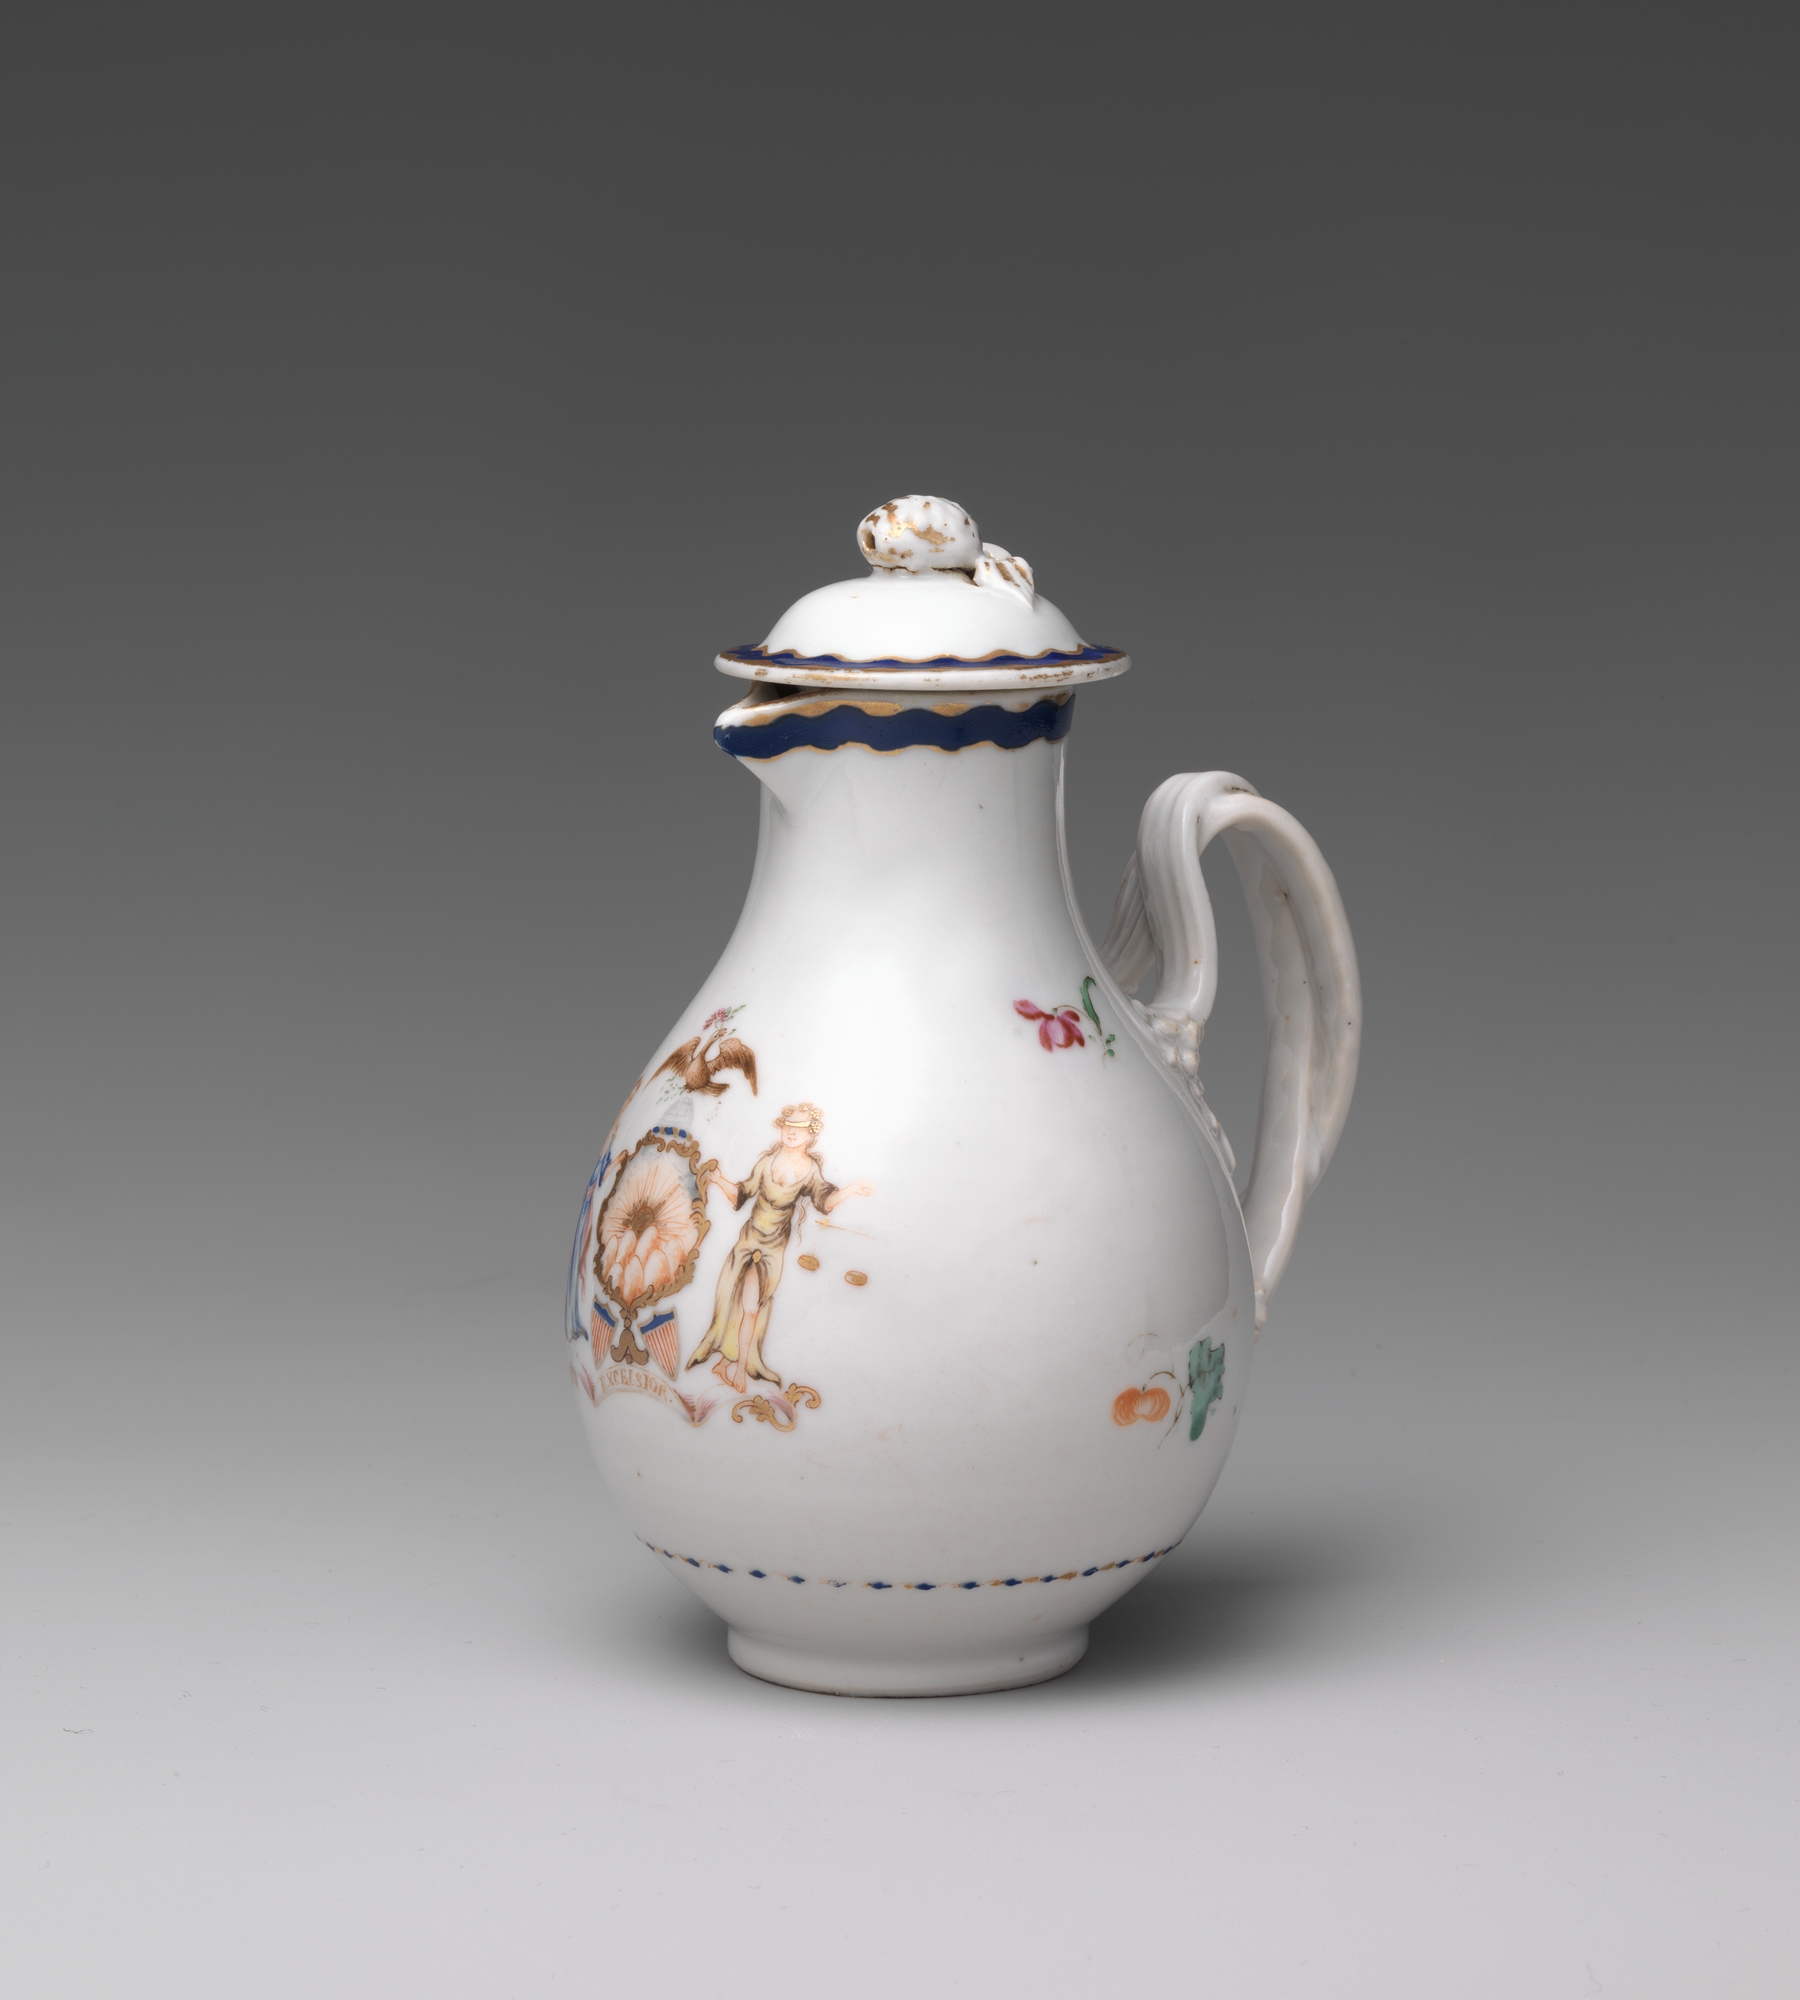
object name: cream pot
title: Creamer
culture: chinese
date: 1785-1805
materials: porcelain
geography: china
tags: coat of arms